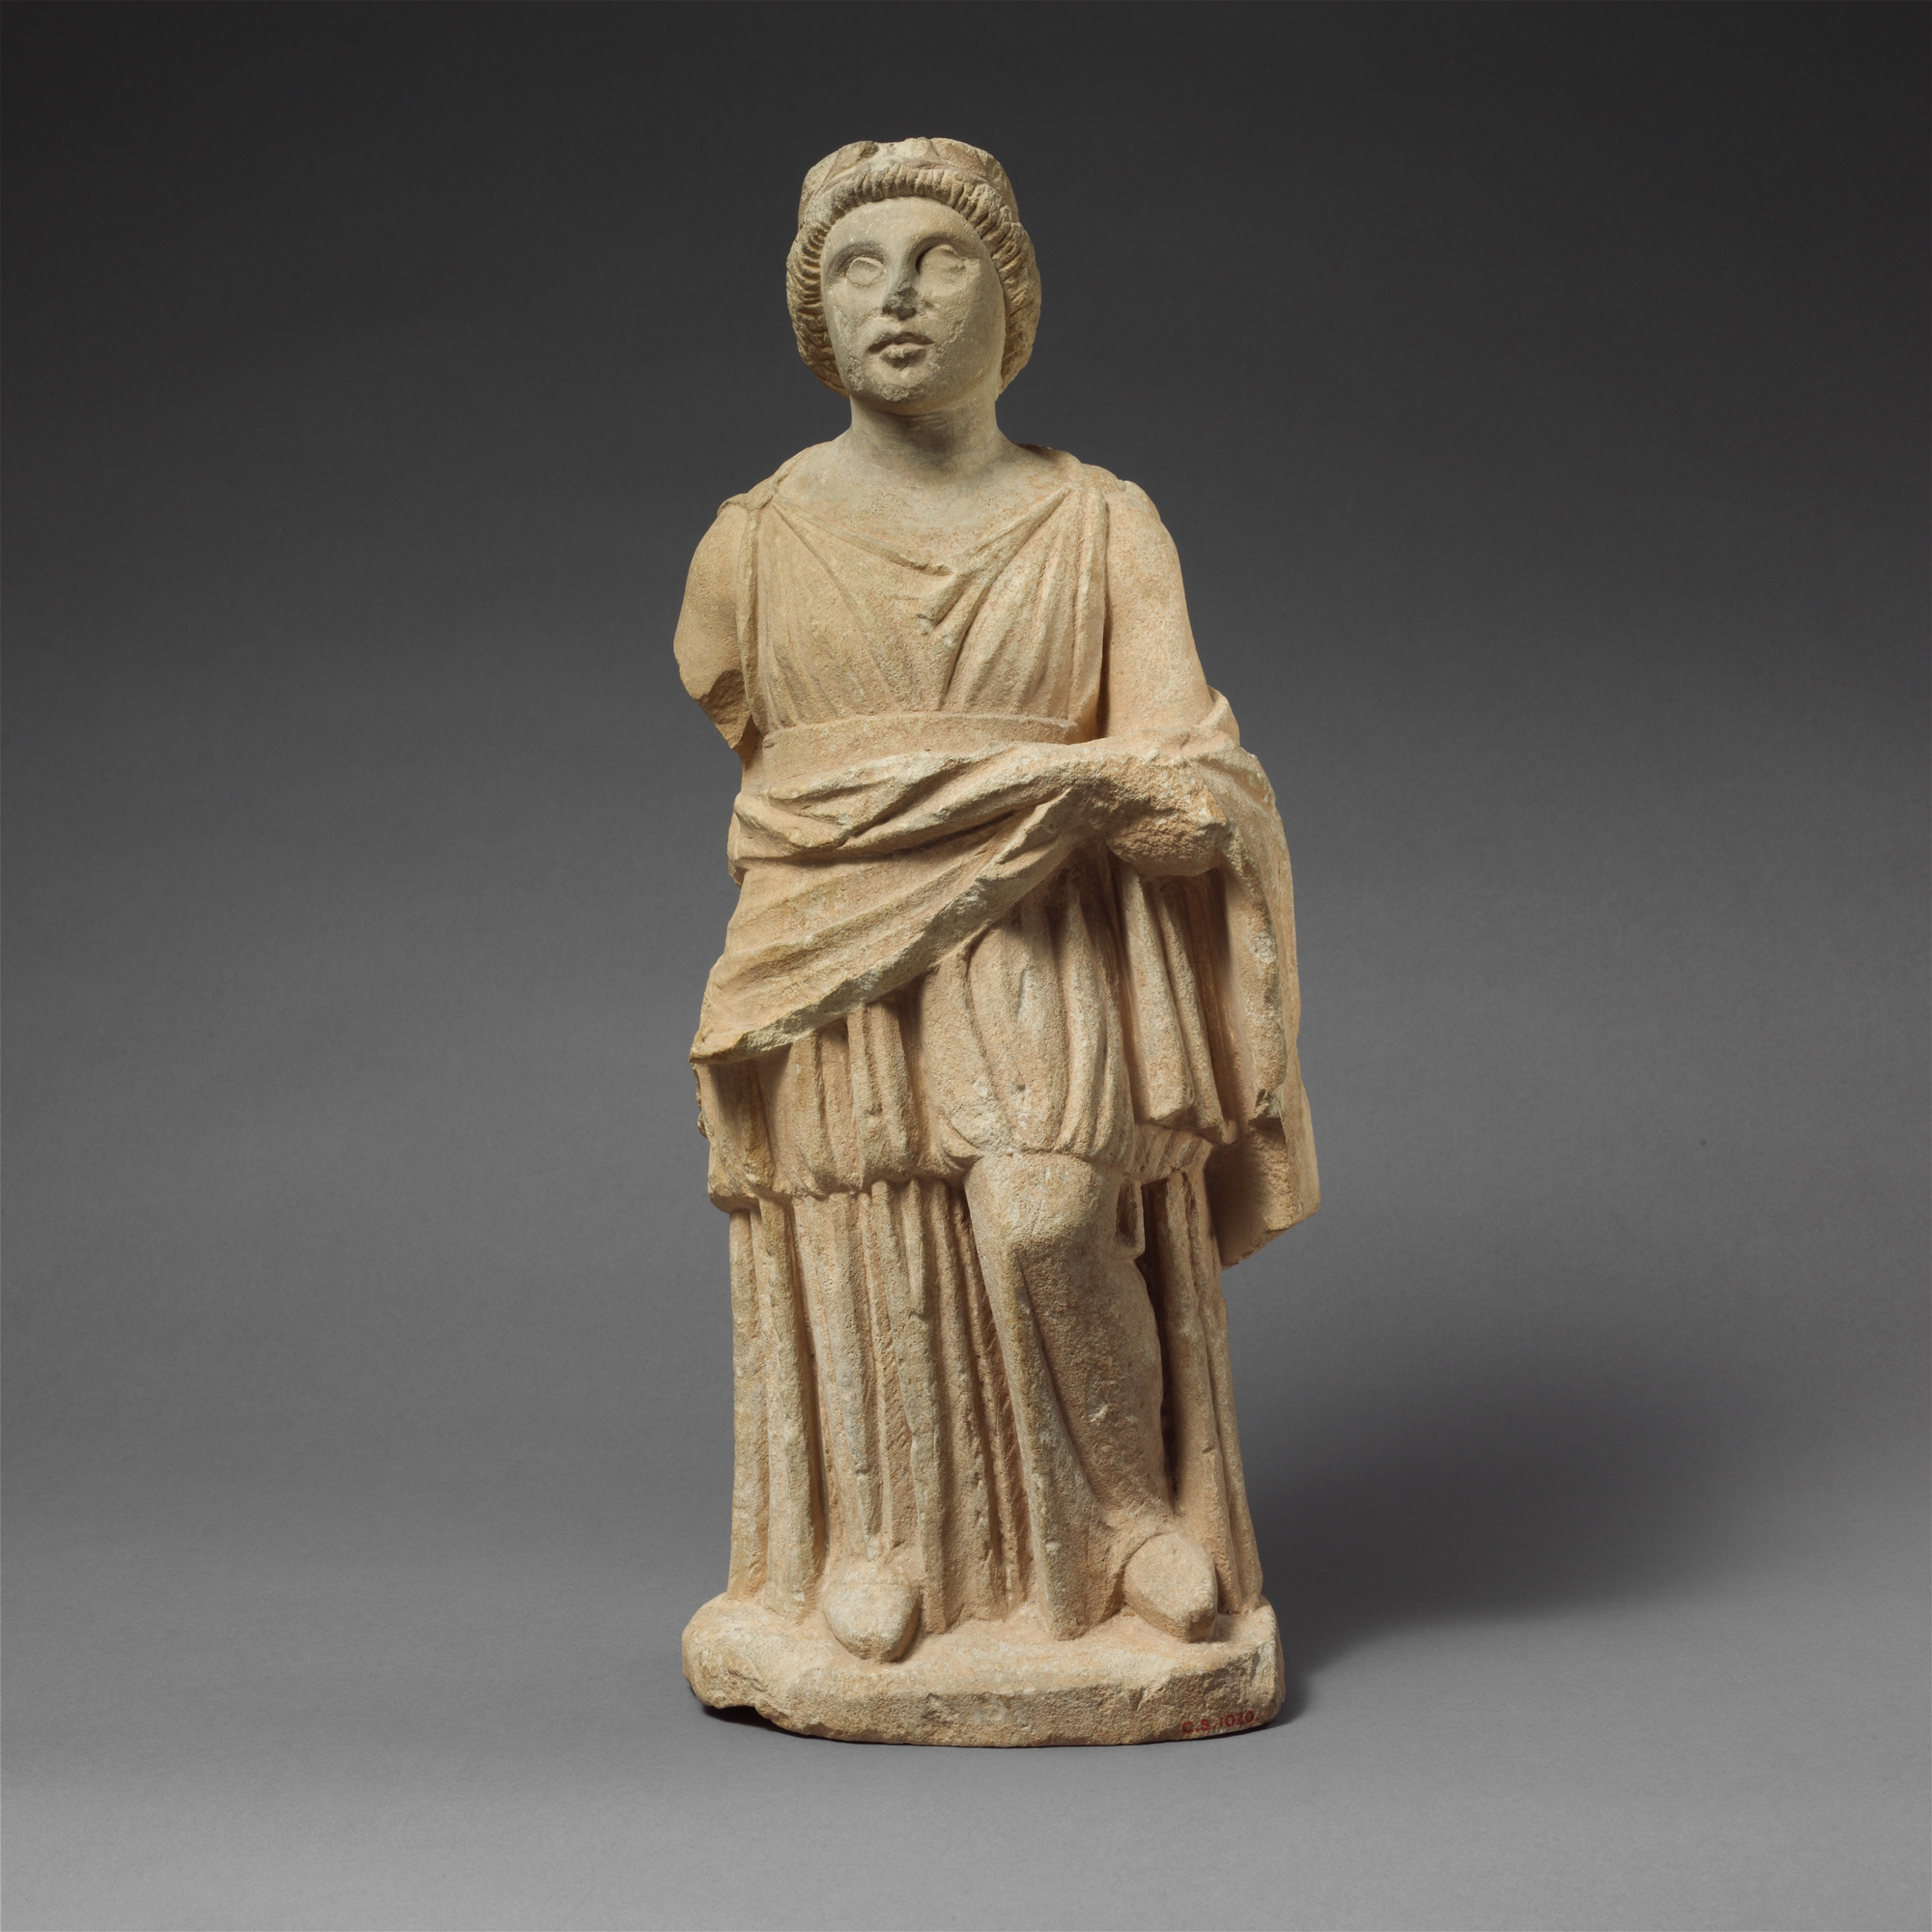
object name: statue of a votary, male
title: Limestone statuette of Apollo(?)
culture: cypriot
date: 300-1 BCE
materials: limestone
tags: apollo